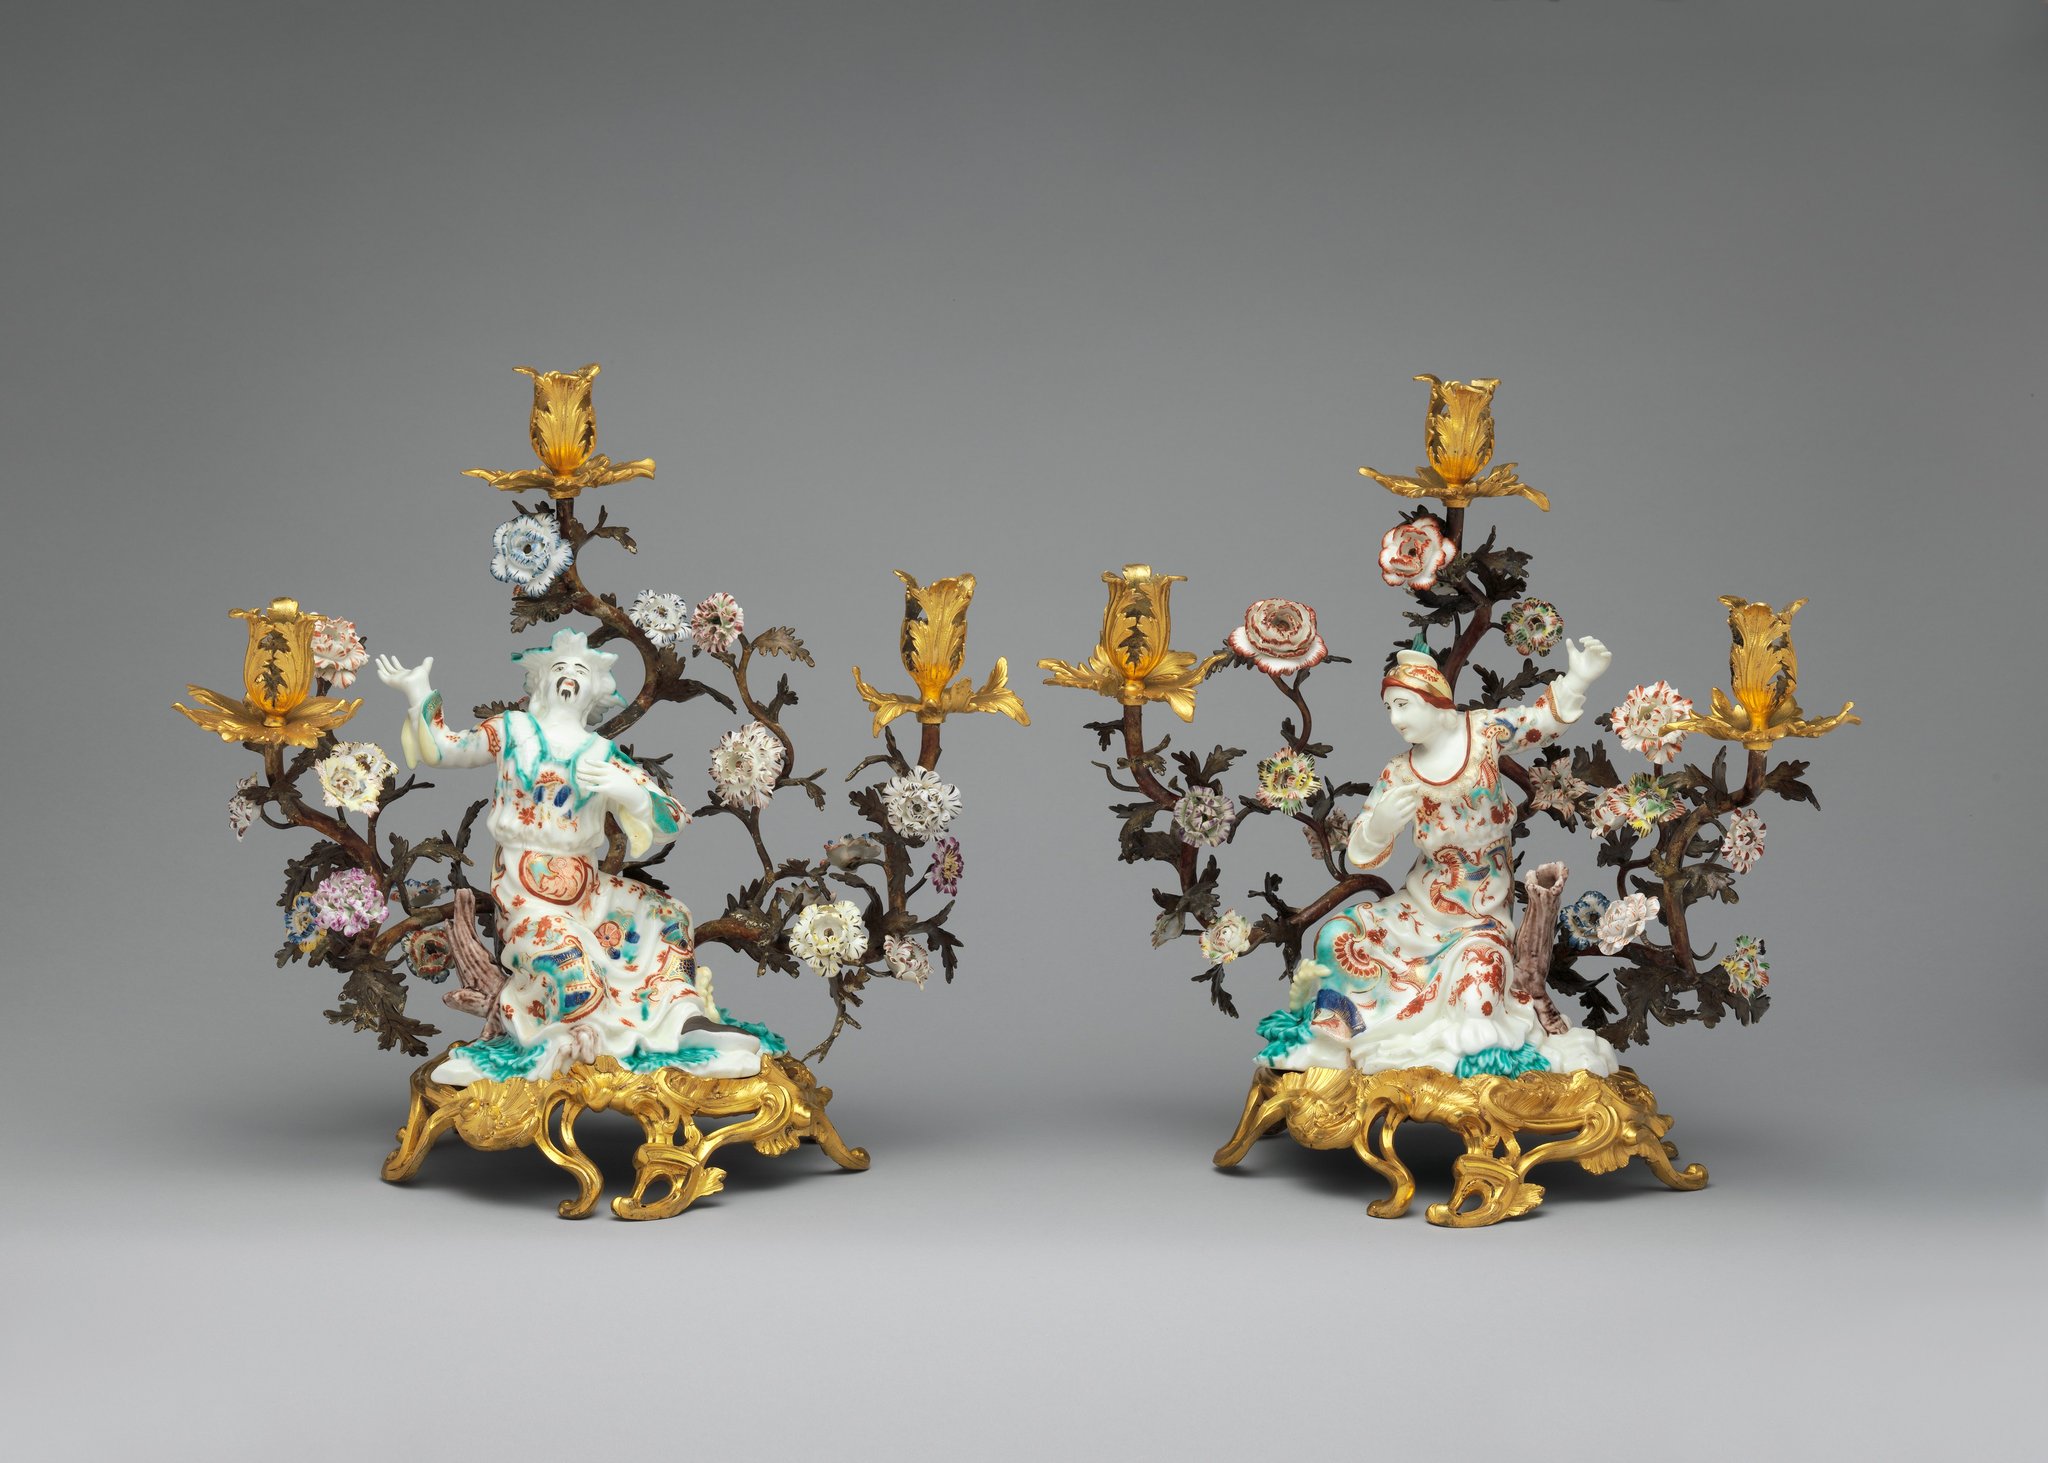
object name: candelabrum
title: Figure mounted as a candelabrum (one of a pair)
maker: saint-cloud factory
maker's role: factory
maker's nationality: french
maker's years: 1693-1766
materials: enamel, gilt bronze, gold, soft paste porcelain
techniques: polychrome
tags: women,flowers